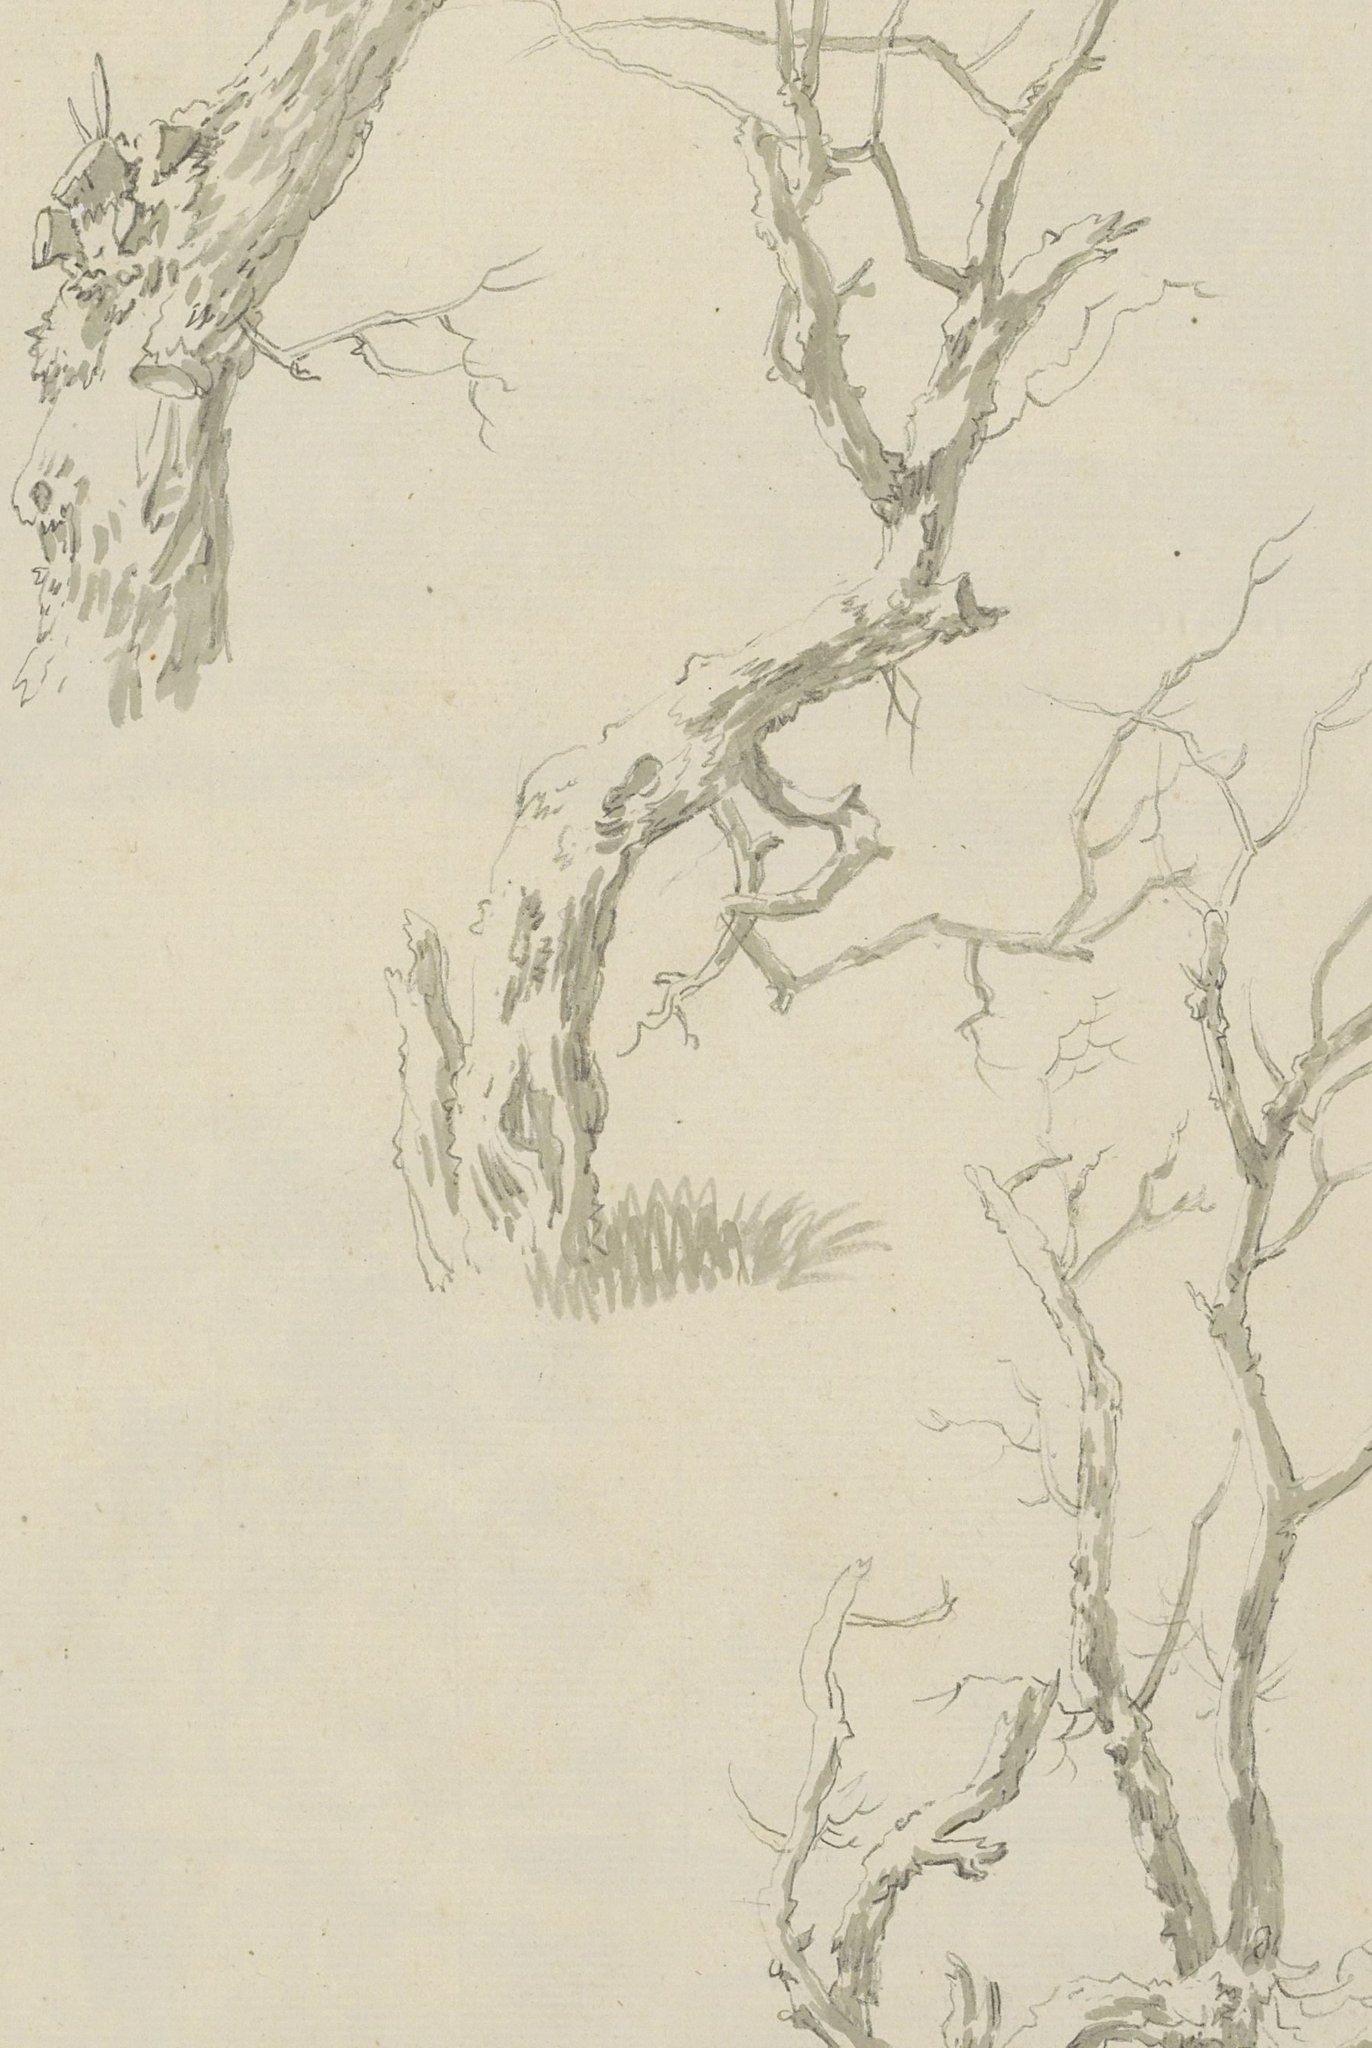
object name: sketchbook leaf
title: Bomen en boomstam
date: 1780-1800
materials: paper, pencil, watercolor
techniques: brush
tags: trees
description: Blad 10 recto uit een schetsboek met 25 bladen.